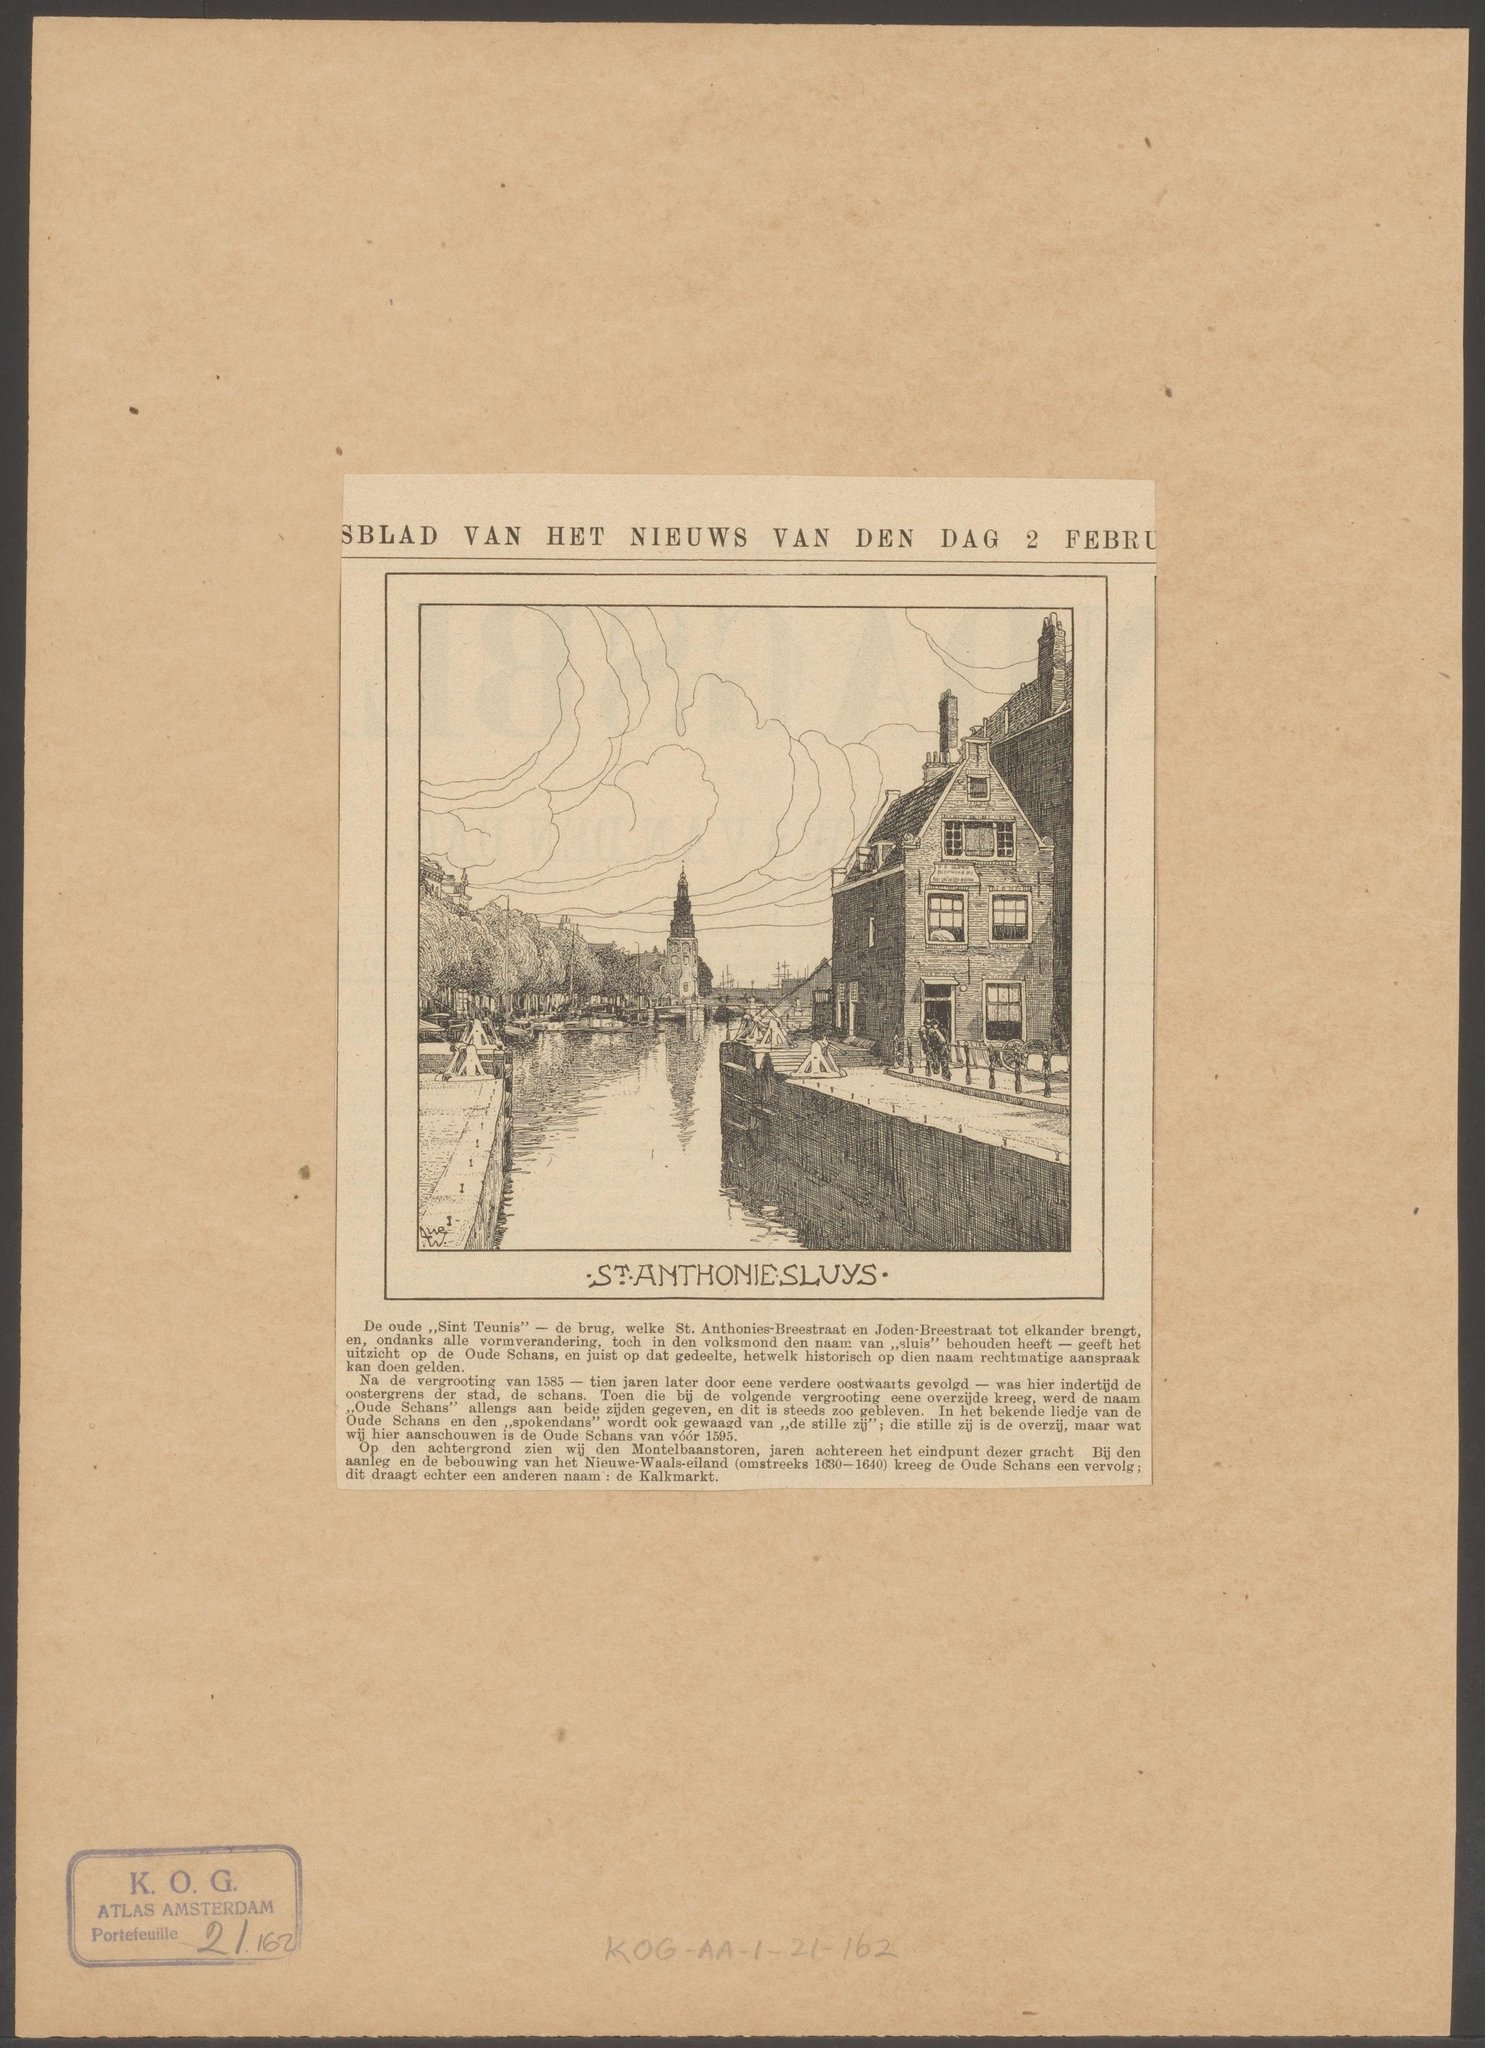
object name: photomechanical print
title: St. Anthoniesluys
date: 1902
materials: paper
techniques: letterpress printing, line block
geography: amsterdam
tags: sluice, weir, lift-lock, canal lock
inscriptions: collector's mark: Lugt 1641b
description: Prent uit: Zondagsblad van Het Nieuws van den Dag (1902), 2 februari 1902. Mogelijk uit de serie: Oud-Amsterdam 100 Stadsgezichten.